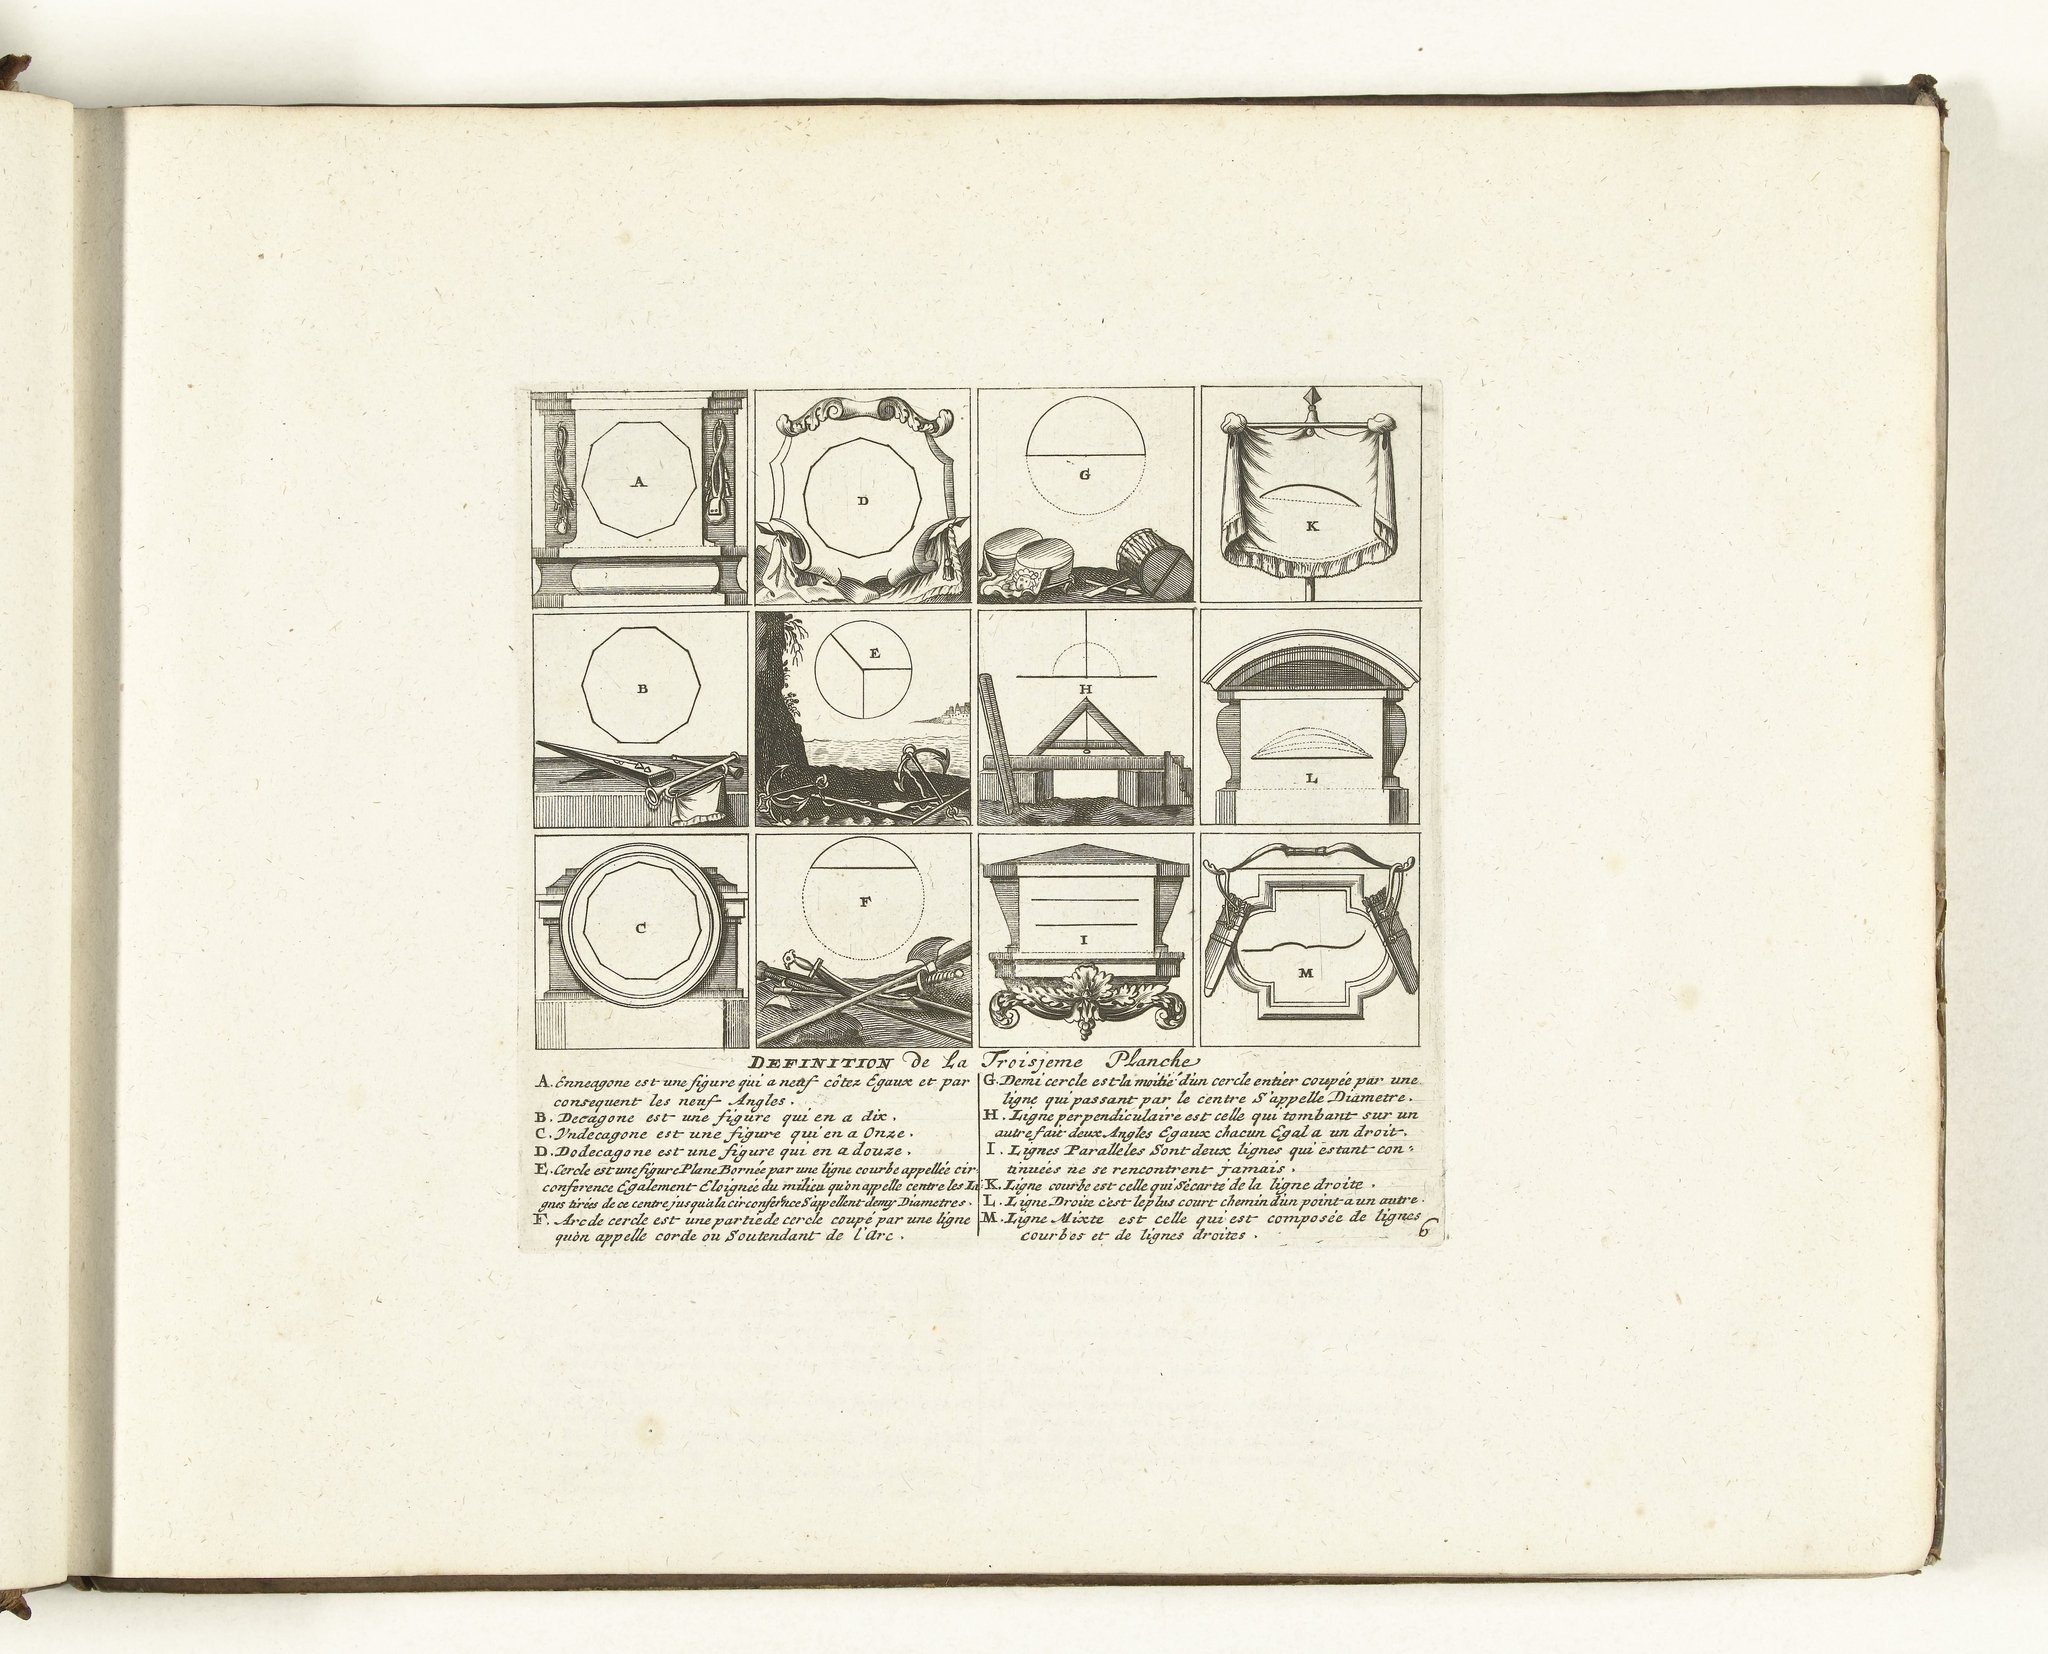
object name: print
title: Derde plaat met figuren in de vestingbouw, 1726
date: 1726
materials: paper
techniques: engraving, etching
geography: northern netherlands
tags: fortifications, military engineering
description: Derde plaat met 12 geometrische figuren toegepast in de vestingbouw. Plaat nr. 6 in deel I van het prentwerk: Les Forces de l'Europe, Asie, Afrique et Amerique ... Comme aussi les Cartes des Côtes de France et d'Espagne uit 1726, dit eerste deel met 238 met de hand genummerde platen van vermaarde sterke steden en vestingen in het kader van de Spaanse Successieoorlog 1701-1713. Voor het merendeel zijn deze platen gekopieerd naar de anonieme Franse platen van vermaarde sterke steden en vestingen: in Les forces de l'Europe en in: Le theatre de la guerre, dans les Pays-Bas, beide oorspronkelijk uitgegeven door Nicolas de Fer te Parijs (1693-1697) in het kader van de Negenjarige Oorlog. Titels en opschriften in het Frans.